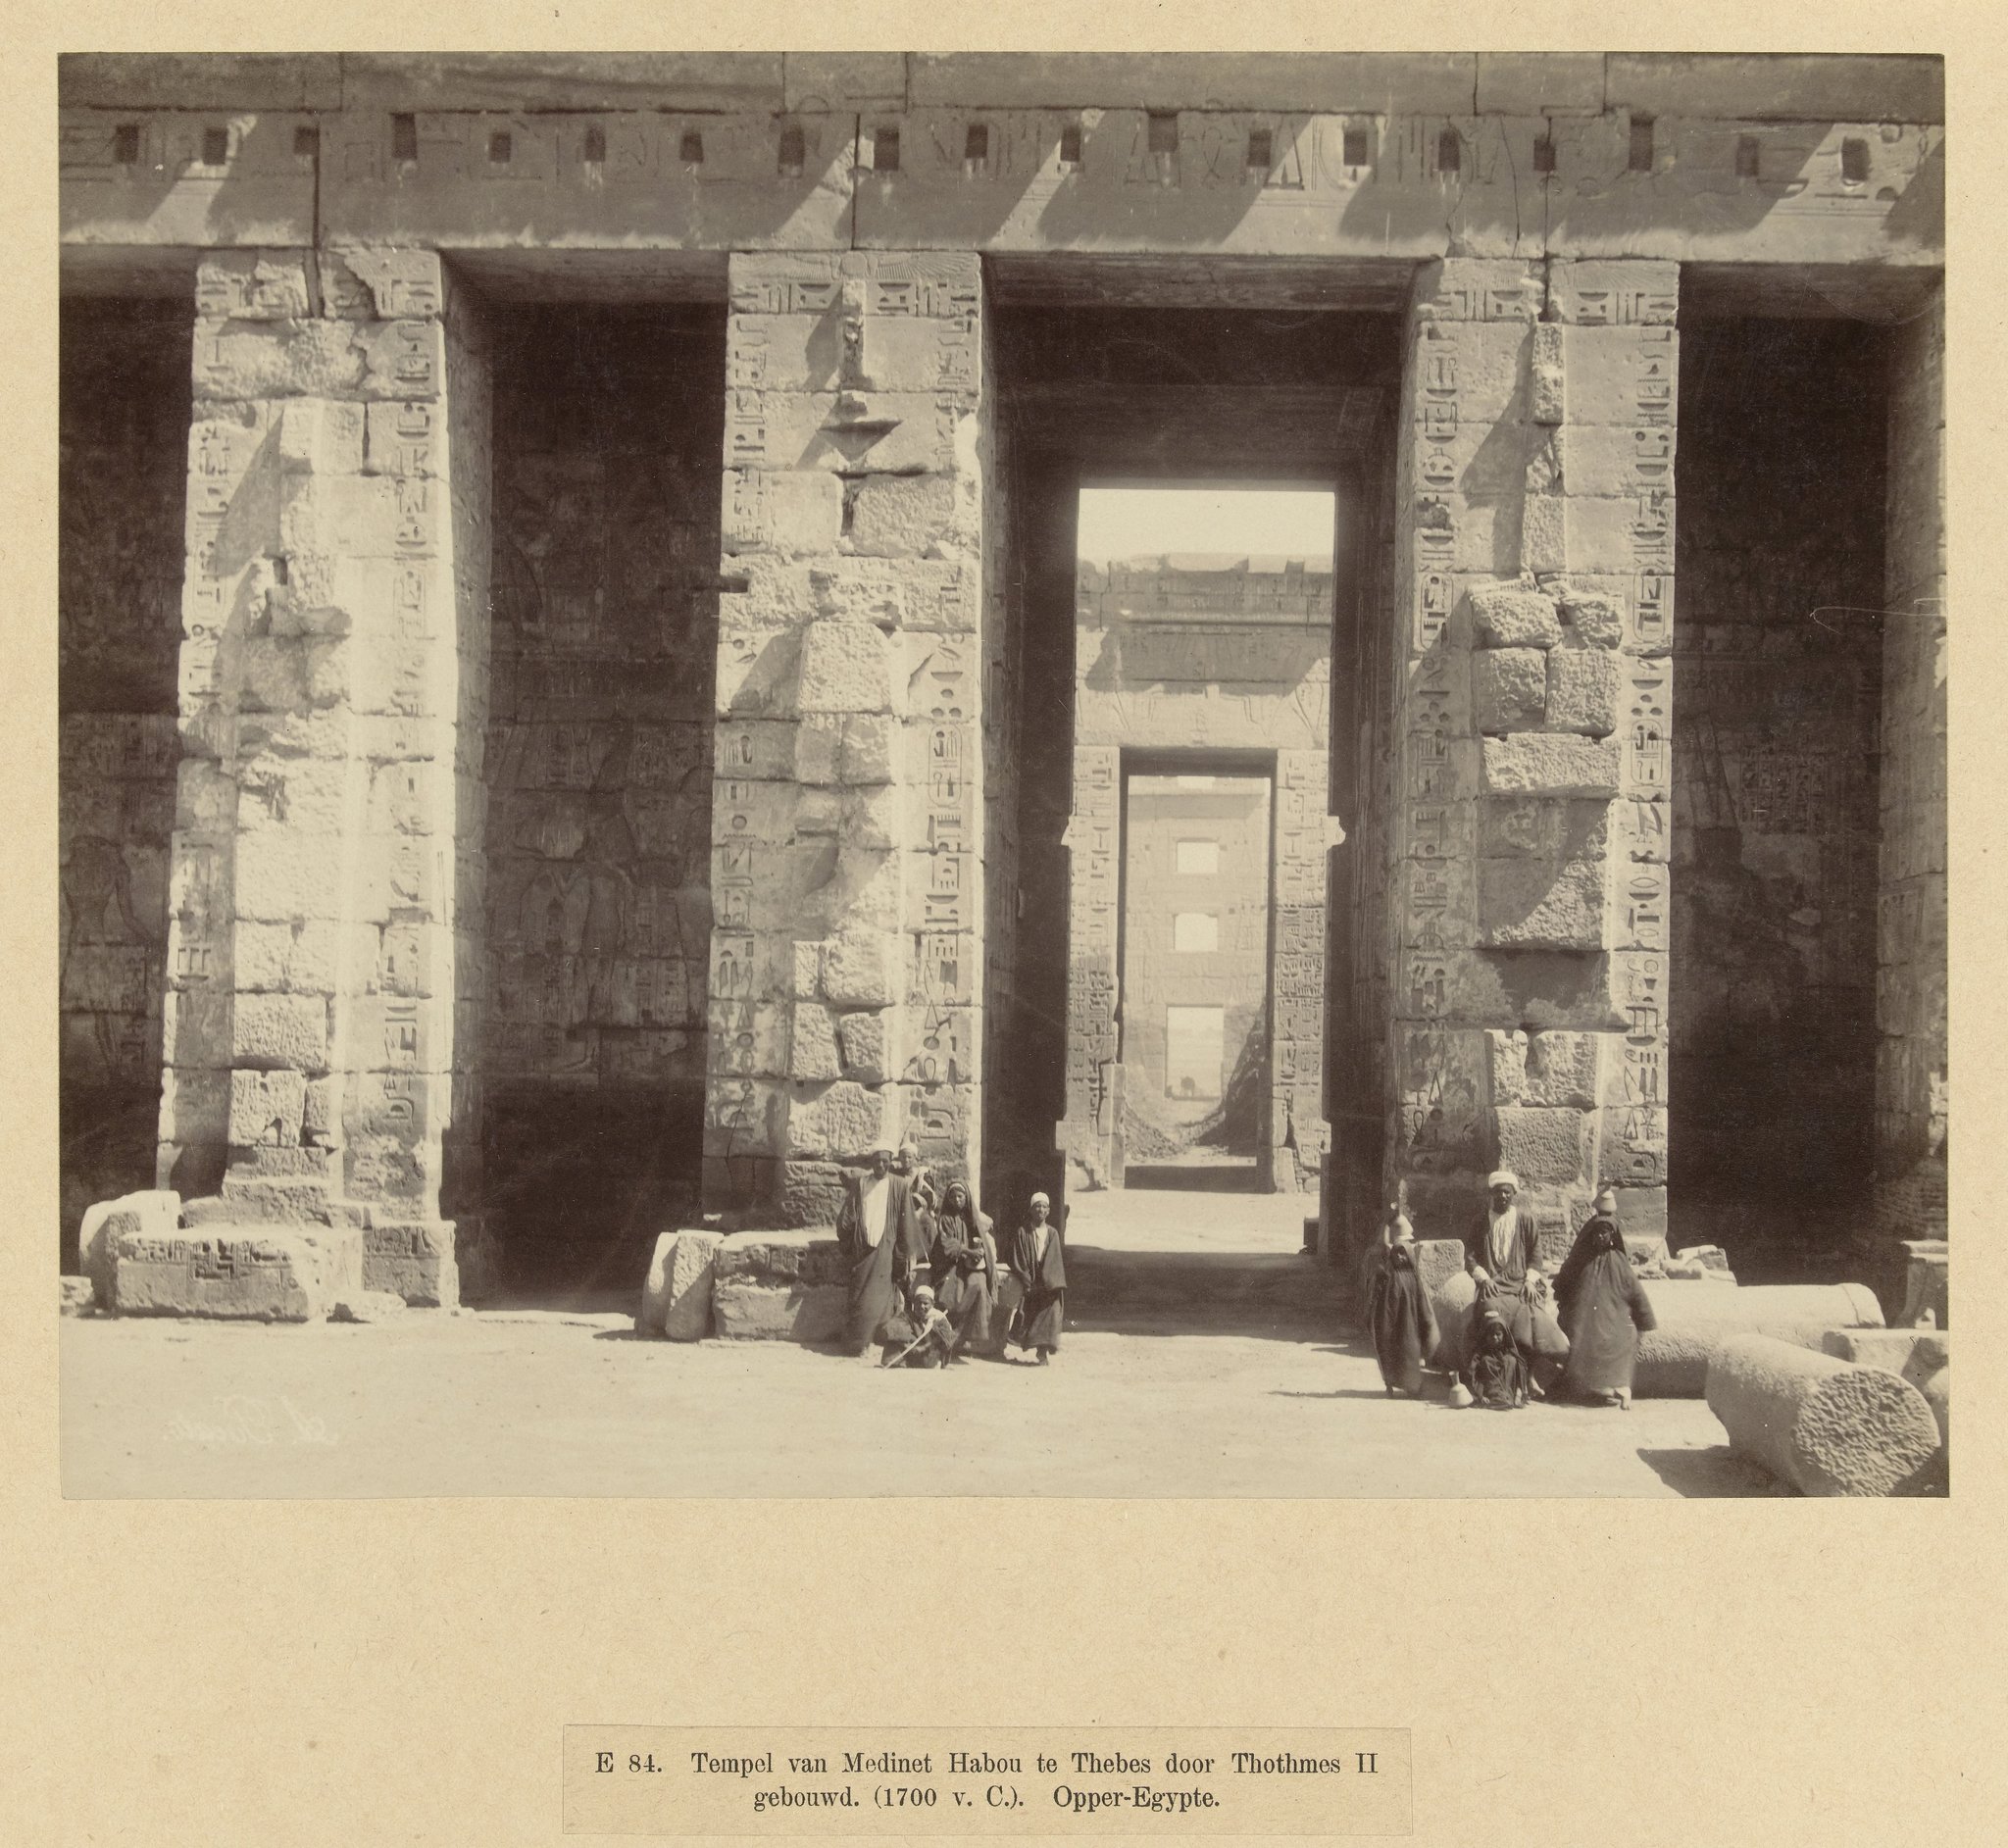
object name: photograph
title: E 84. Tempel van Medinet Habou te Thebes door Thothmes II gebouwd (1700 v. C.). Opper-Egypte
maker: antonio beato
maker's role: fotograaf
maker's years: 1835-1906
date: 1862-1895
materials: cardboard, paper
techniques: albumen print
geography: thebes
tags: temple, shrine ~ egyptian religion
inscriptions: stamp: ‘GEMEENTELIJKE BIBLIOTHEEK/ ROTTERDAM’, title: ‘E 84. Tempel van Medinet Habou te Thebes door Thothmes II gebouwd (1700 v. C.). Opper-Egypte.’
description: Onderdeel van een groep door fotograaf Richard Polak op reis verzamelde foto’s. Deze foto is samen met andere op zijn reizen verzamelde foto's tentoongesteld bij de Rotterdamsche Kunstkring (1895), Arti en Amicitiae te Amsterdam (1897-1898?) en Societeit 't Collegie te Kampen (datum vooralsnog onbekend).